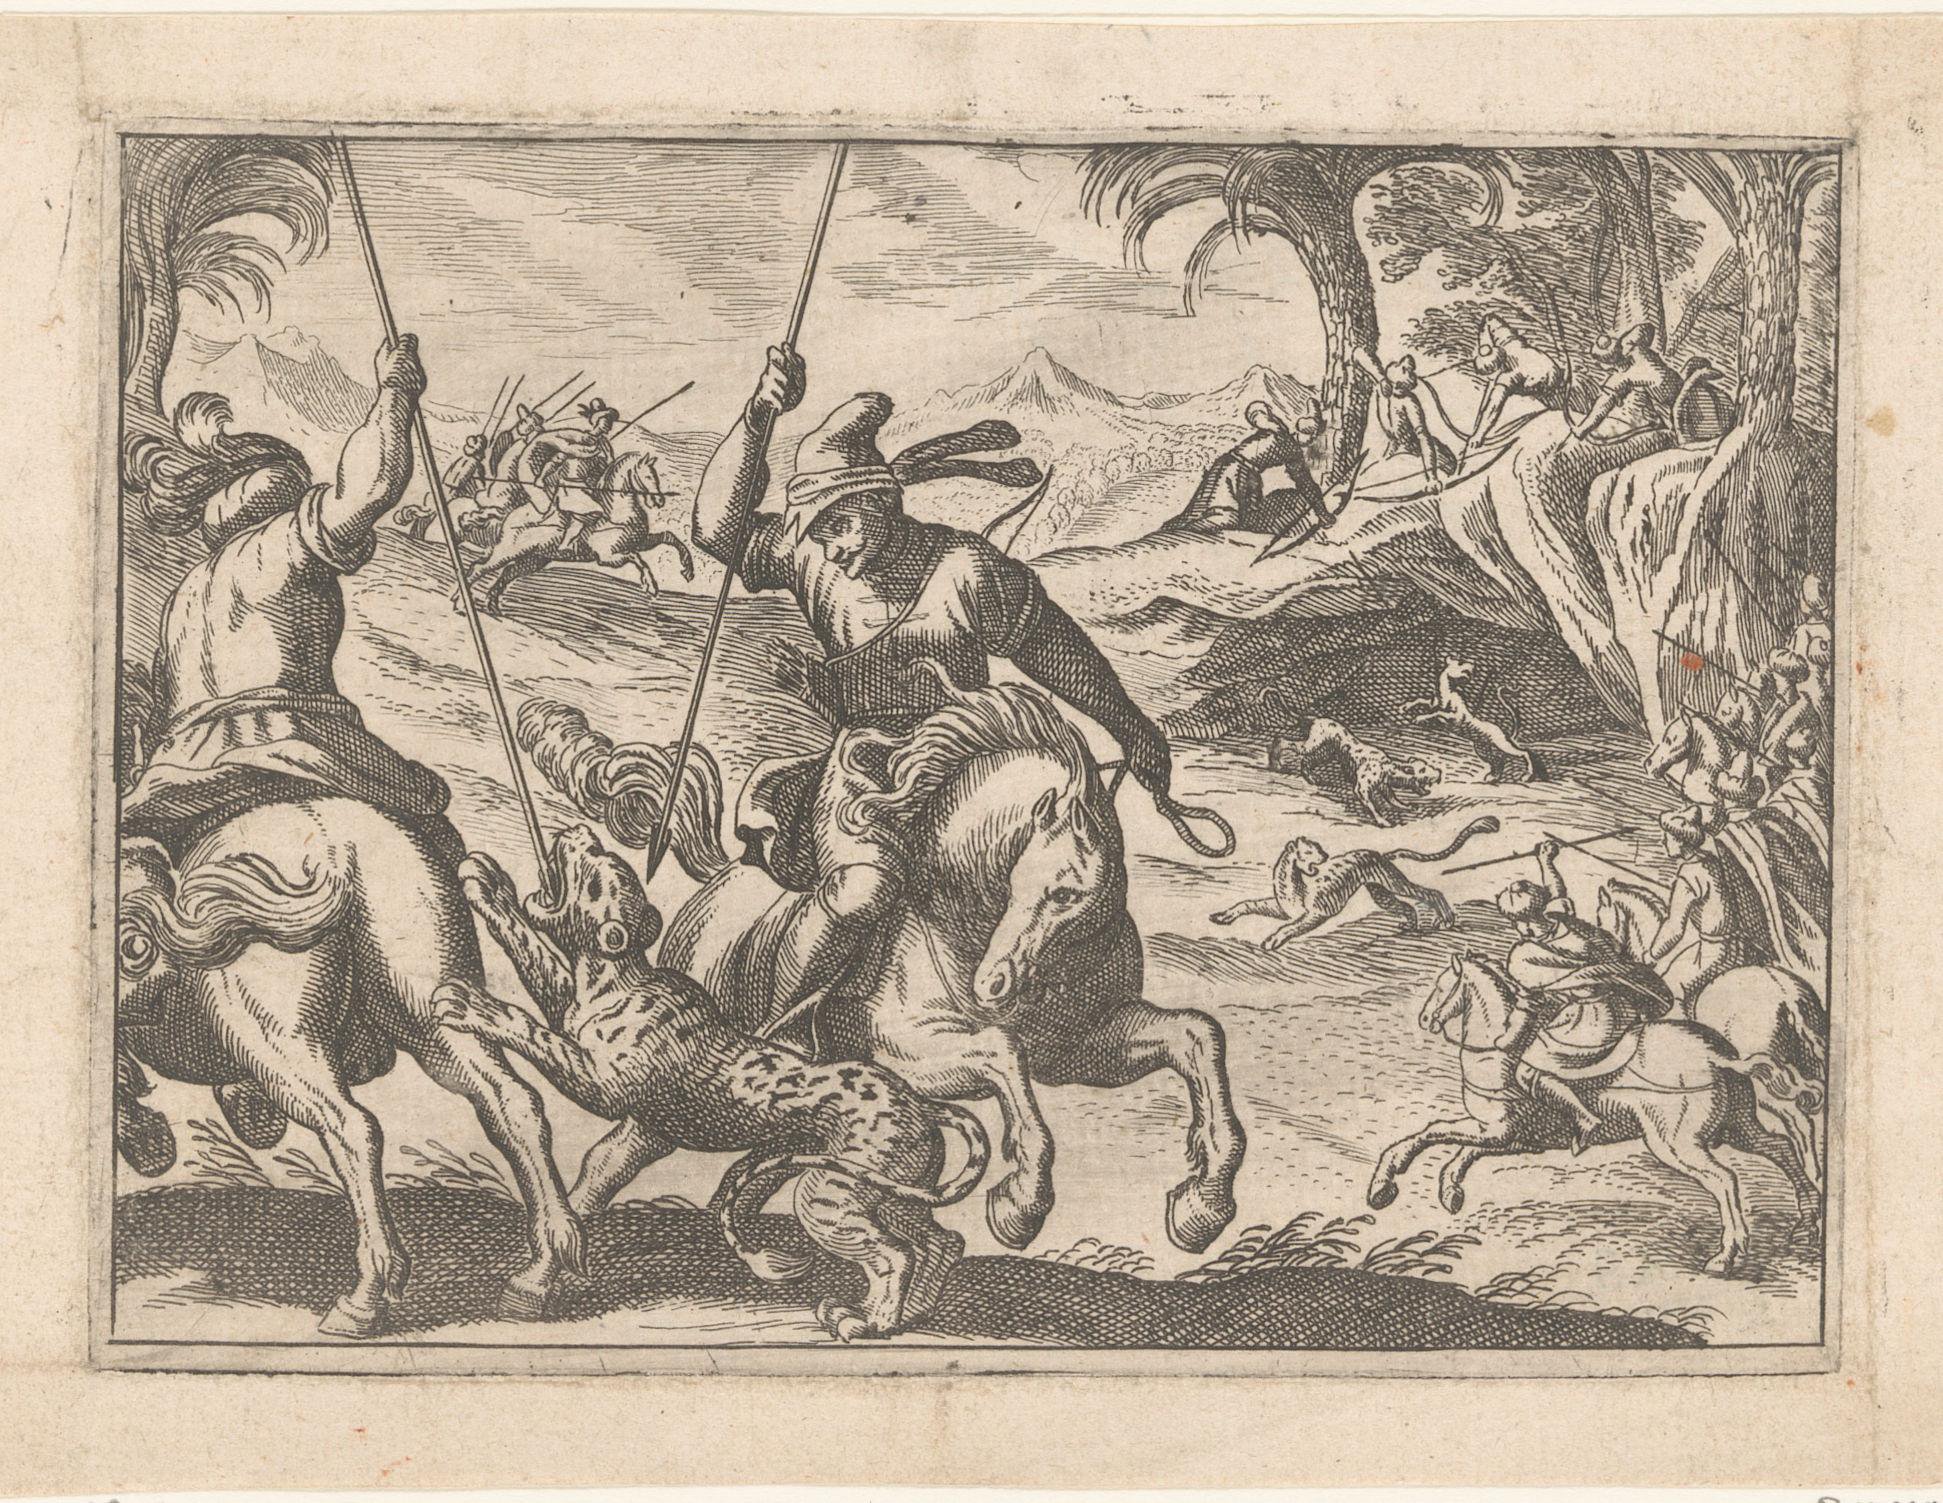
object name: print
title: Jachtscènes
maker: Anonymous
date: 1598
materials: paper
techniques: etching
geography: italy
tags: beasts of prey, predatory animals: leopard, hunter, hunters hunting (n.b.: in 1988-1990 this notation denoted the concept of 43c11421 'hunters resting during the hunt')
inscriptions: collector's mark: Lugt 2165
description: Deze prent maakt deel uit van een reeks jachtscènes. De originele serie door Antonio Tempesta bestaat uit 45 jachtscènes (+ opdracht en titelprent).